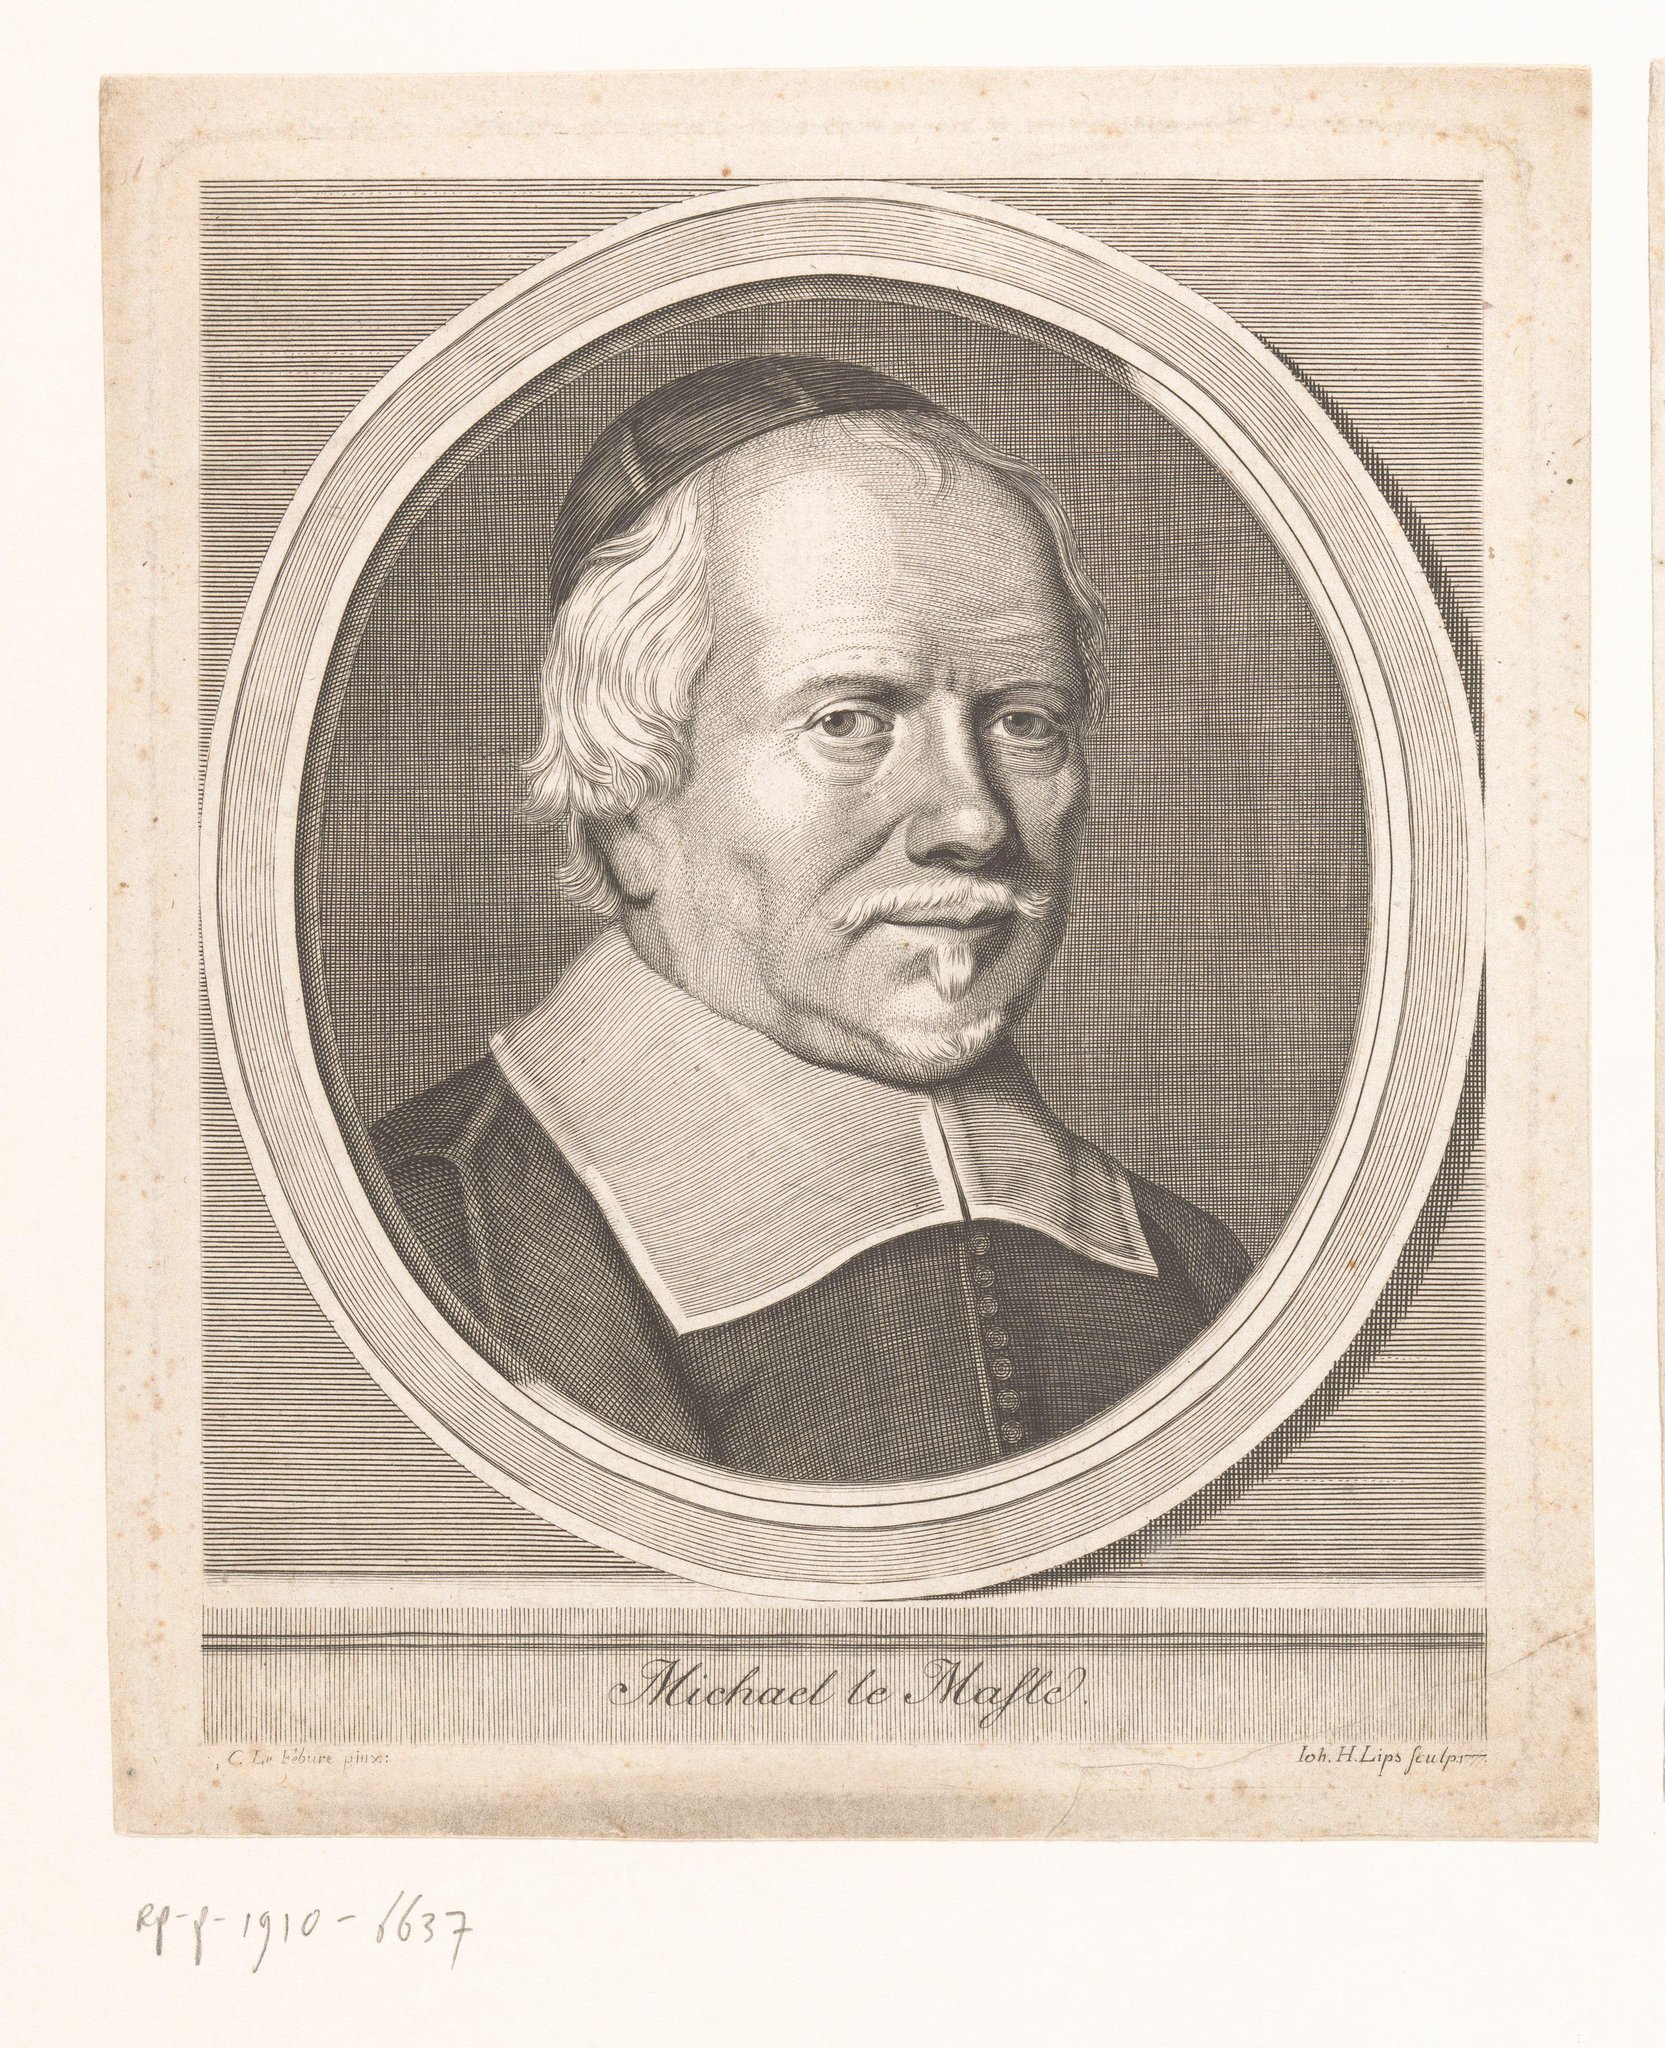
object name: print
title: Portret van Michel le Masle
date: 1777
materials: paper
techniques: engraving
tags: michel le masle, theologian, historical persons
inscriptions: collector's mark: Lugt 2228